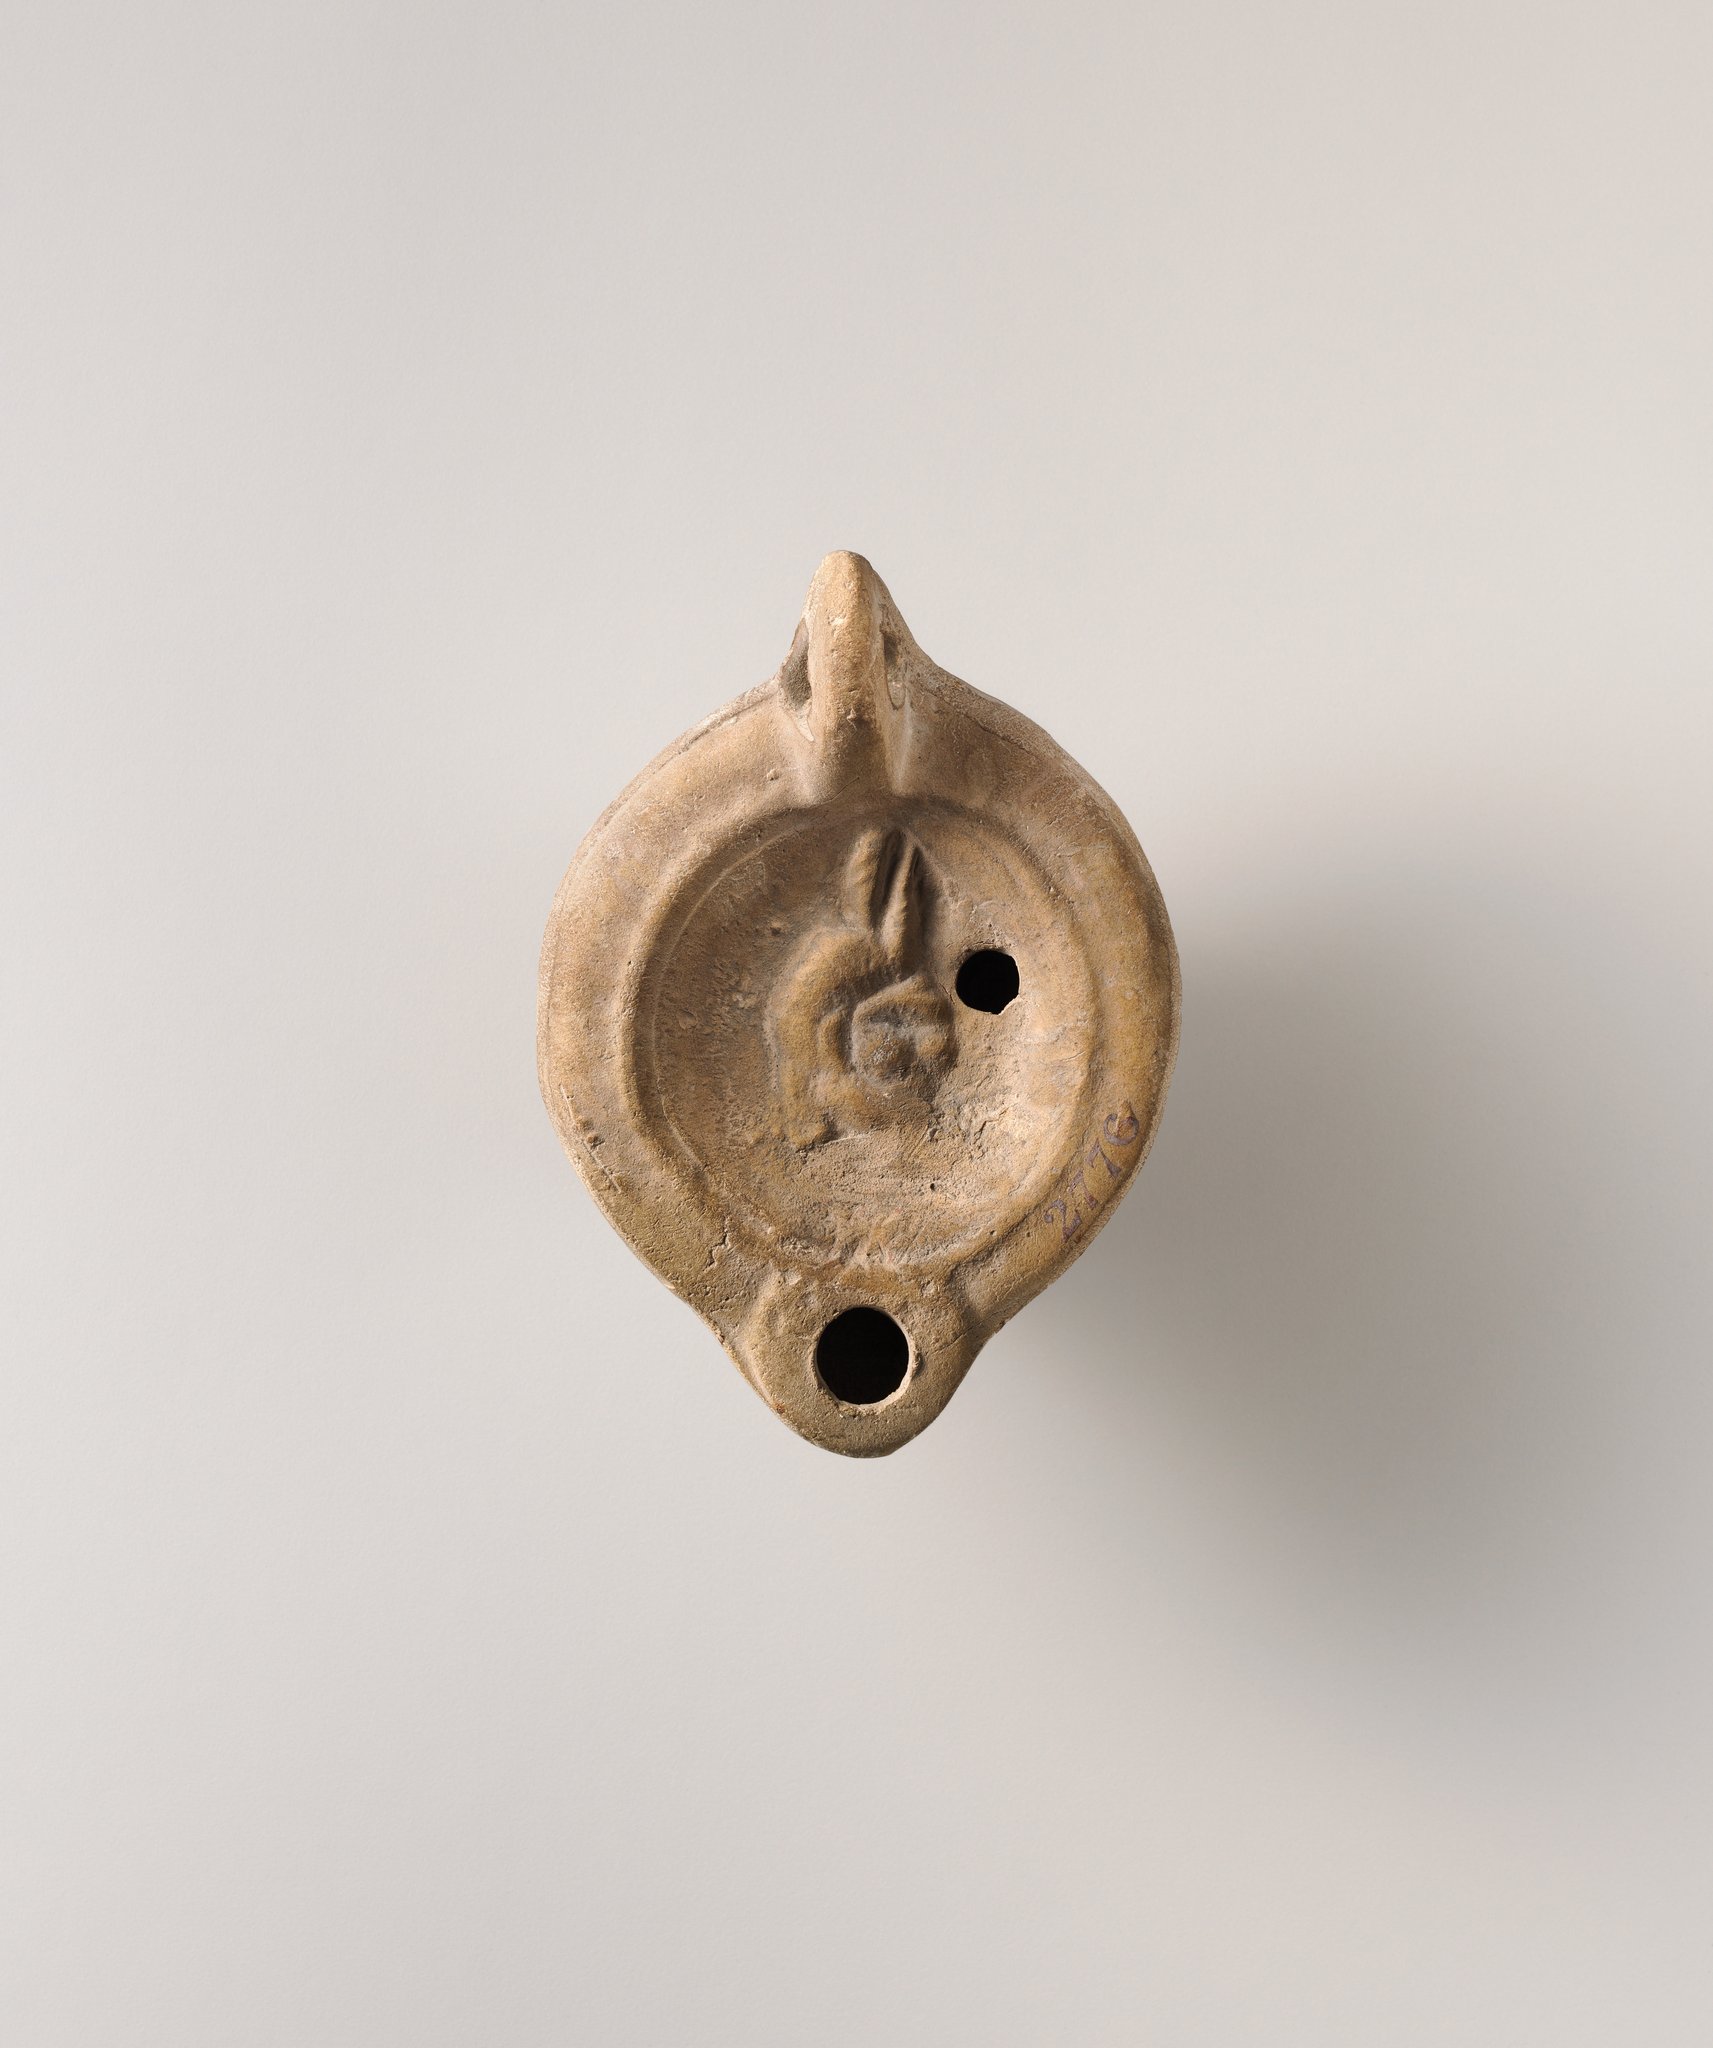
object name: lamp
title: Terracotta oil lamp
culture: roman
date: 101-200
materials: terracotta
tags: pan